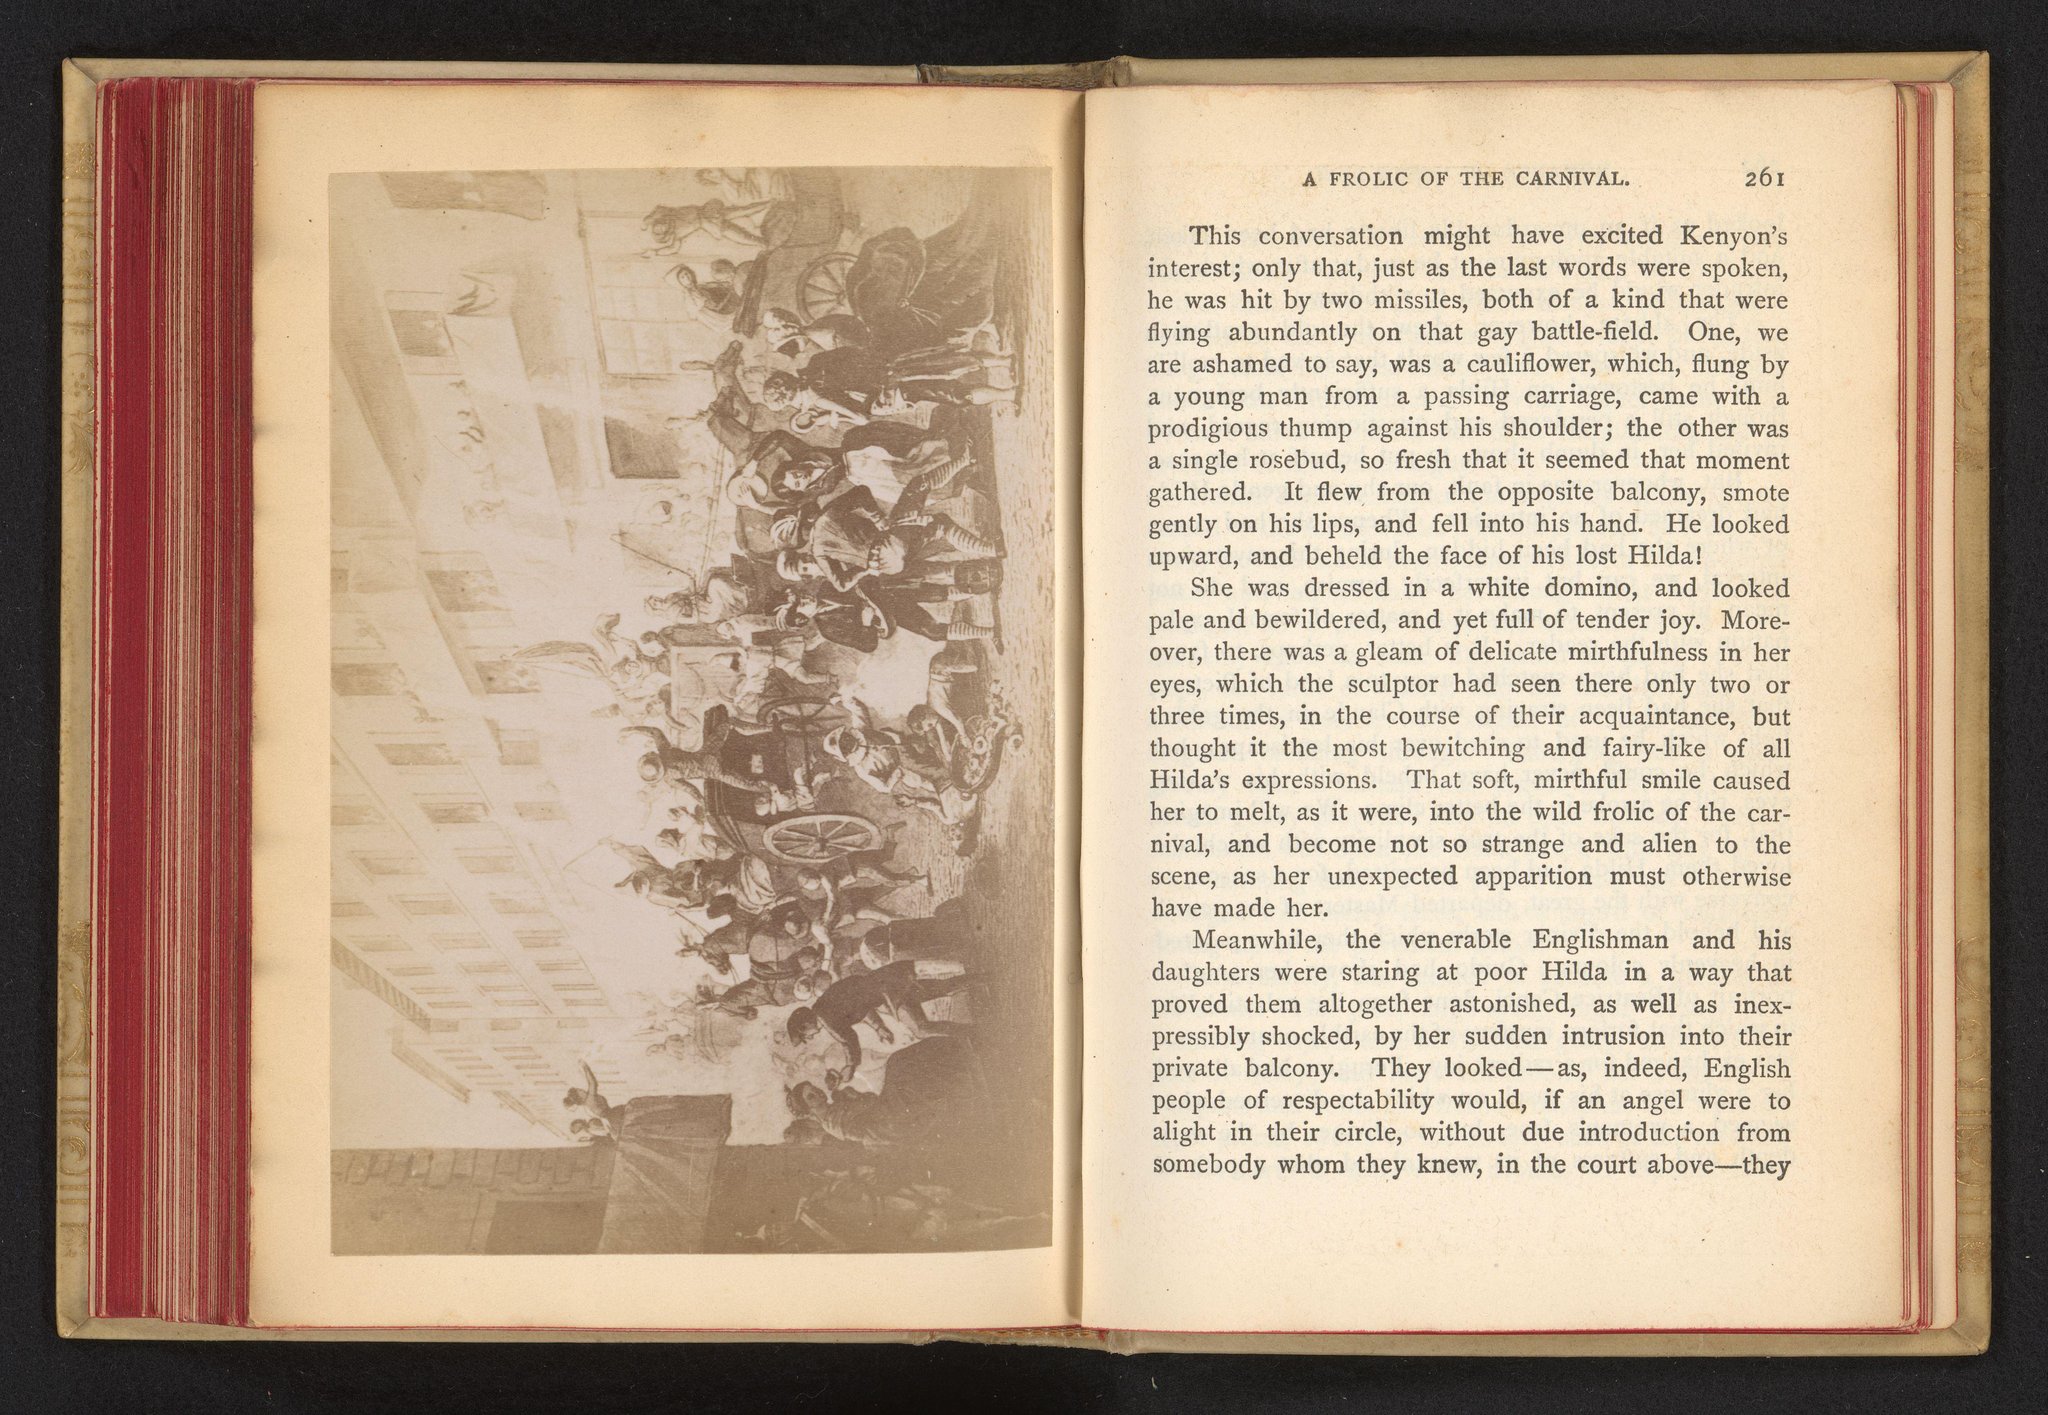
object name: reproduction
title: Fotoreproductie van een tekening van carnaval in de Via del Corso in Rome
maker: Anonymous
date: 1855-1860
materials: paper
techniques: albumen print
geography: rome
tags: carnival, shrovetide (non-liturgical celebration)